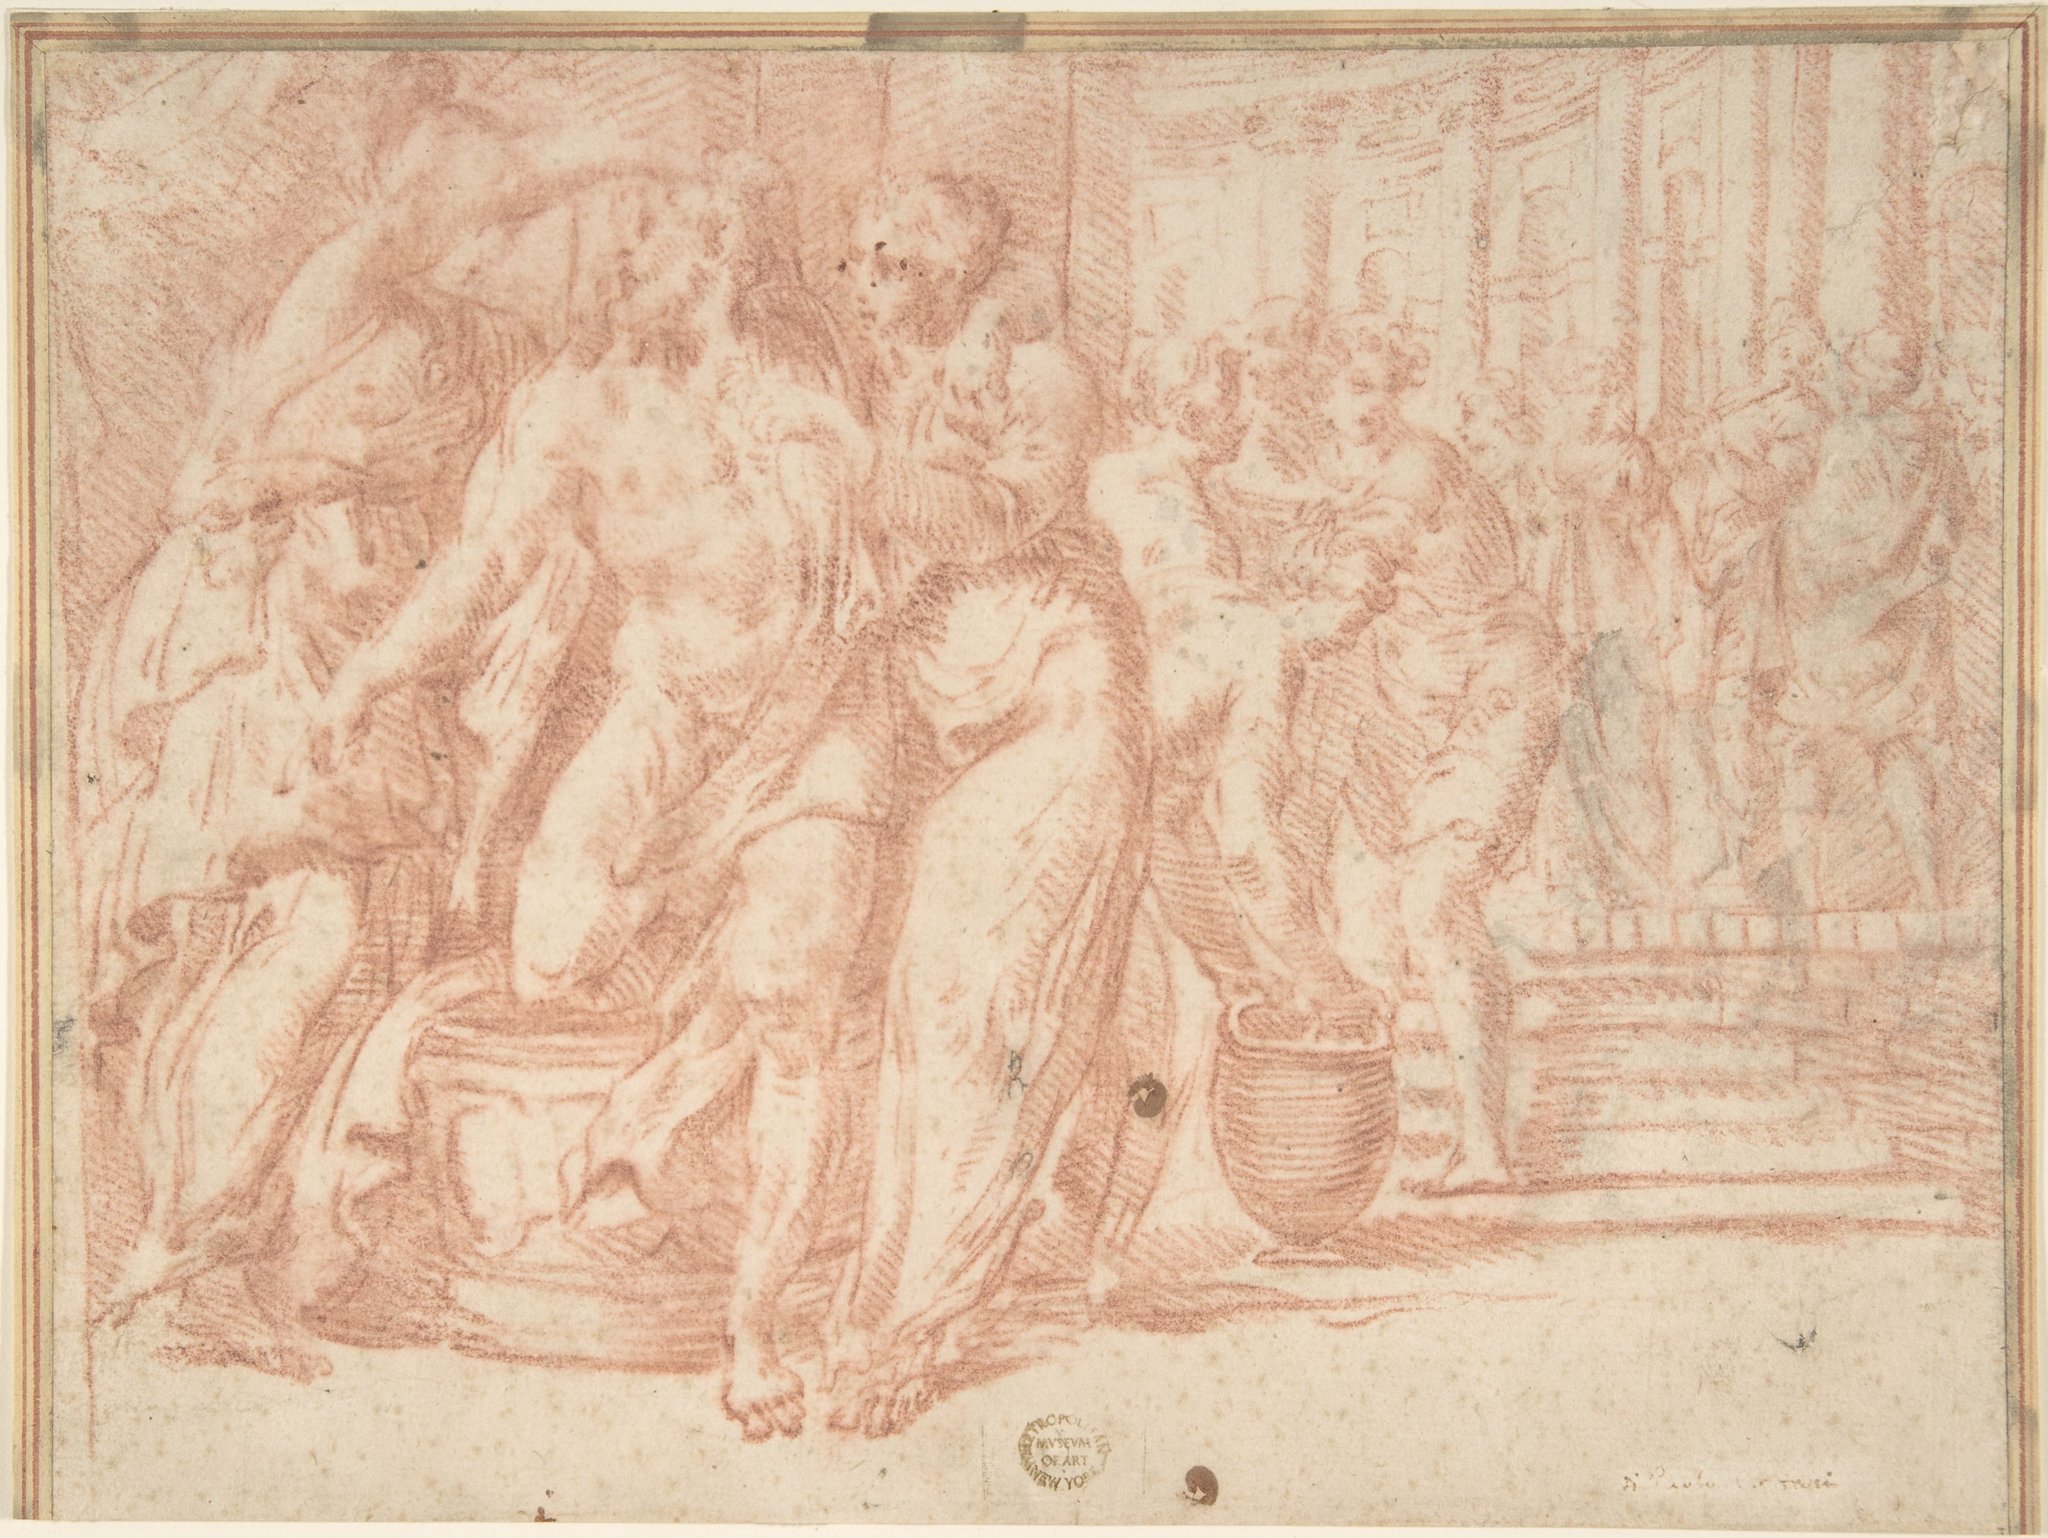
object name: drawing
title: Minerva Beautifies Ulysses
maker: anonymous, italian, 19th century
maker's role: artist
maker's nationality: italian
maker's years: 1800-1900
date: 1801-1900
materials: chalk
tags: men,women,minerva